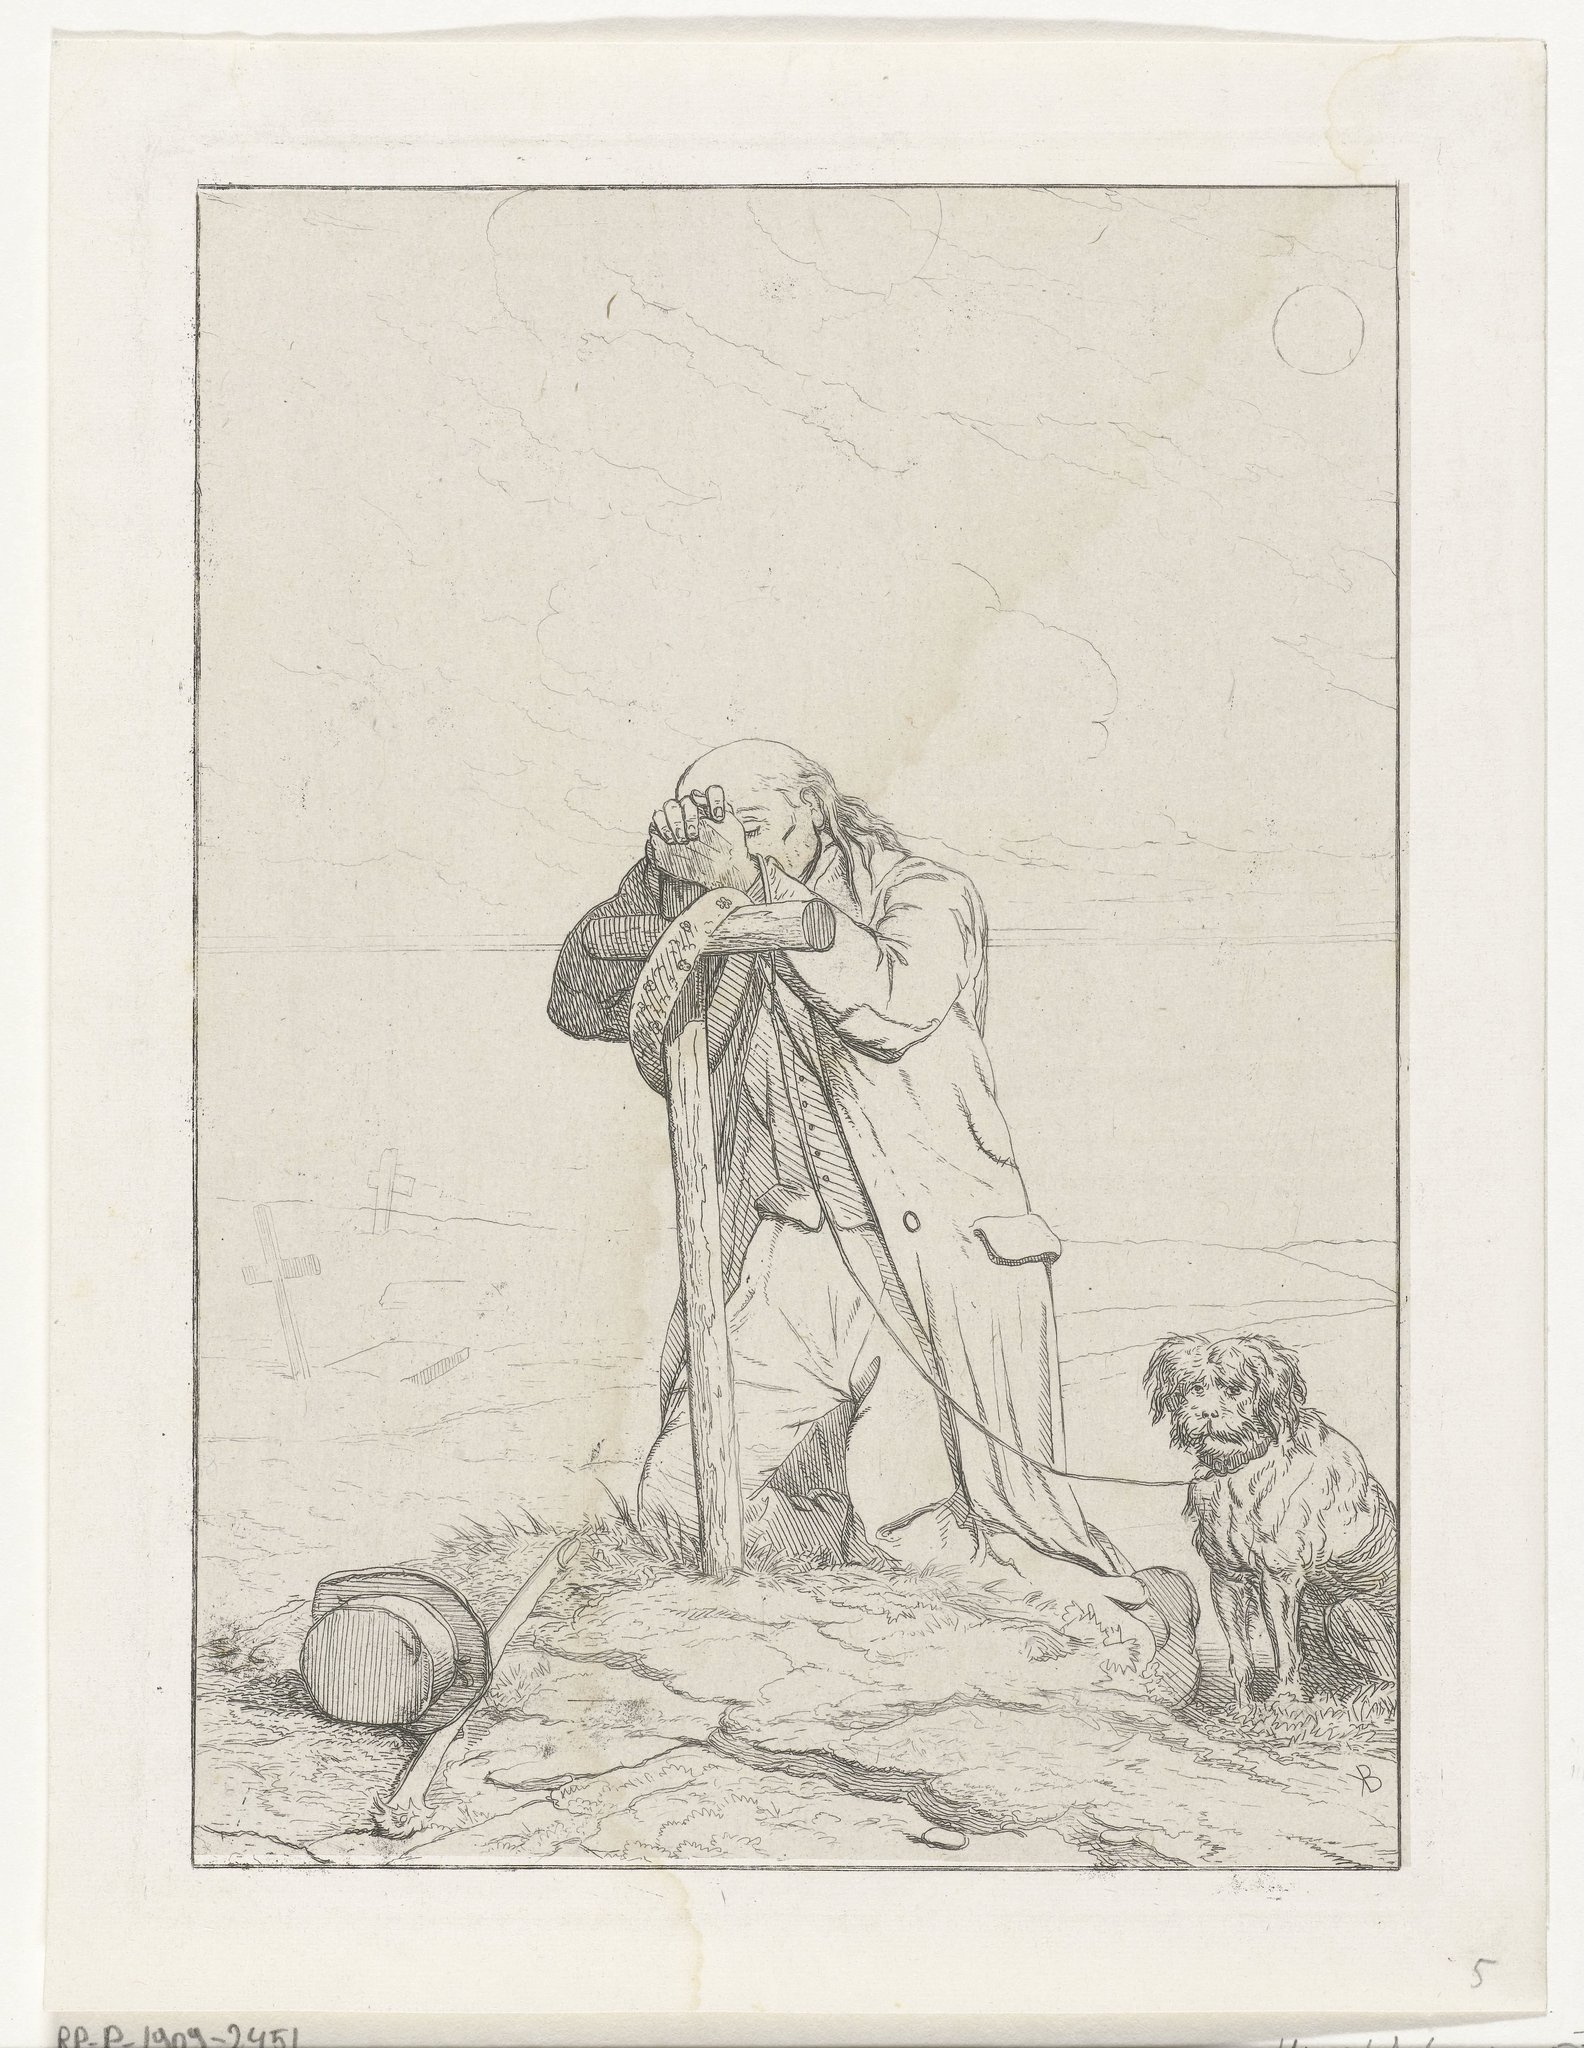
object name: print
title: Bedelaar bij een begraafplaats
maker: karel frederik bombled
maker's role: draughtsman, print maker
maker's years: 1822-1902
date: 1832-1902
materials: paper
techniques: etching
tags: churchyard (around church), other kinds of grave-markers, e.g. cross, beggar, dog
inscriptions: collector's mark: Lugt 1485, collector's mark: Lugt 2228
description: Een bedelaar zit op zijn knieën te bidden voor een graf. Zijn hond zit links van hem. Zijn hoed en staf rechts. Op de achtergrond zijn meerdere graven te zien. Het is volle maan.